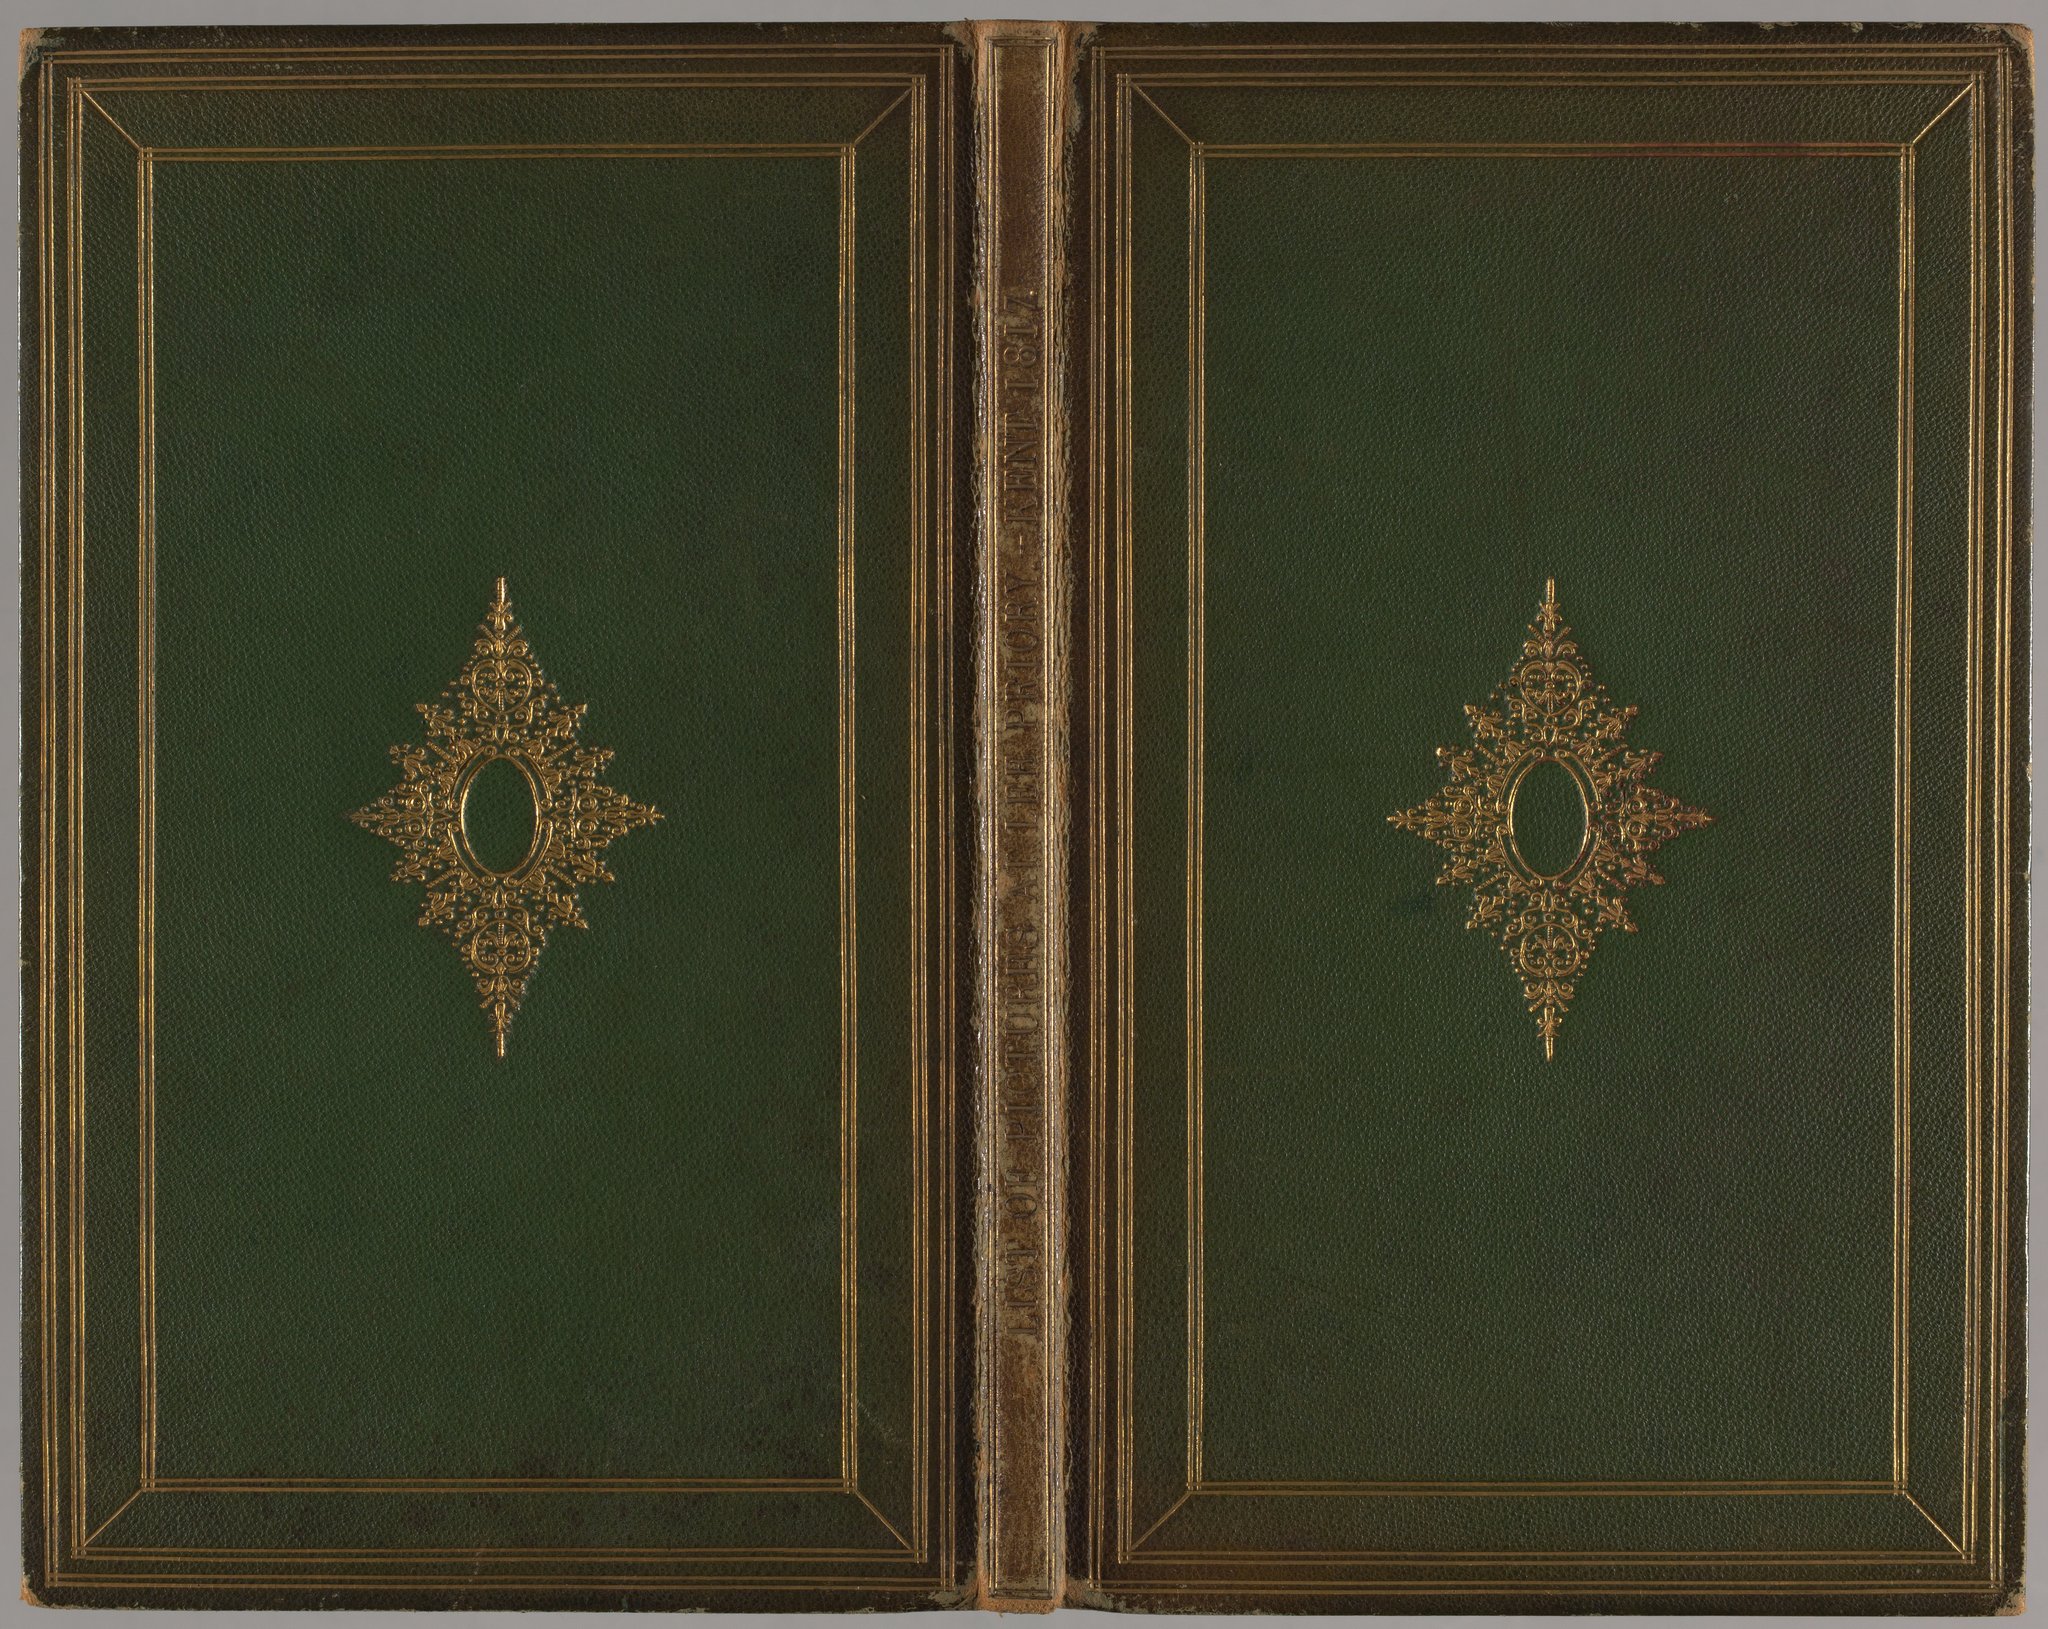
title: List of pictures at the seat of T.B. Brydges Barret, Esq. : at Lee Priory, in the county of Kent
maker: sir egerton brydges, 1st baronet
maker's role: author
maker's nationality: british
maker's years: 1762-1837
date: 1817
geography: england